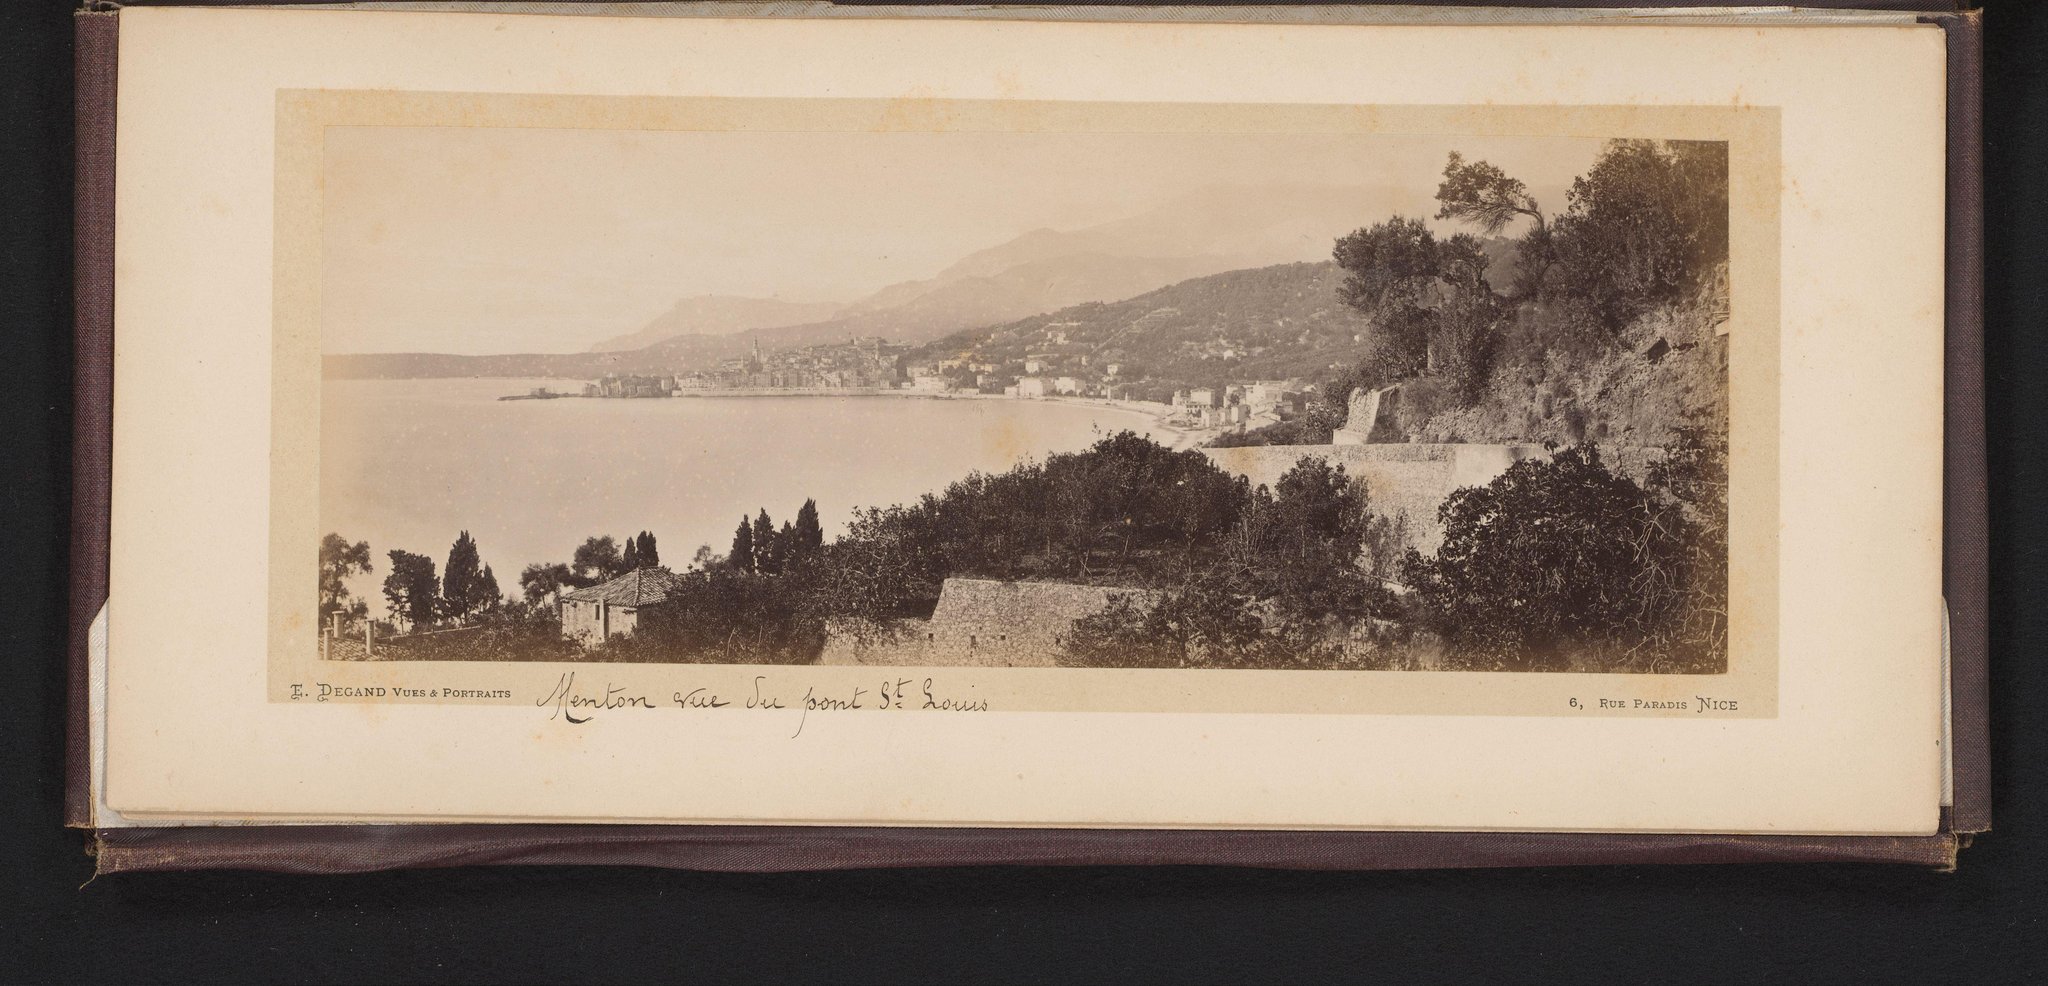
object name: blad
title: Gezicht op een baai, vermoedelijk Menton of vanaf Menton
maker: eugène degand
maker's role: painter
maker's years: 1829-1911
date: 1872-1874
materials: cardboard, photographic support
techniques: albumen print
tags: gulf, bay, mountains, france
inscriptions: annotation: ‘Menton vue du pont St. Louis’, inscription: ‘E. Degand Vues&Portraits 6, Rue Paradis Nice’